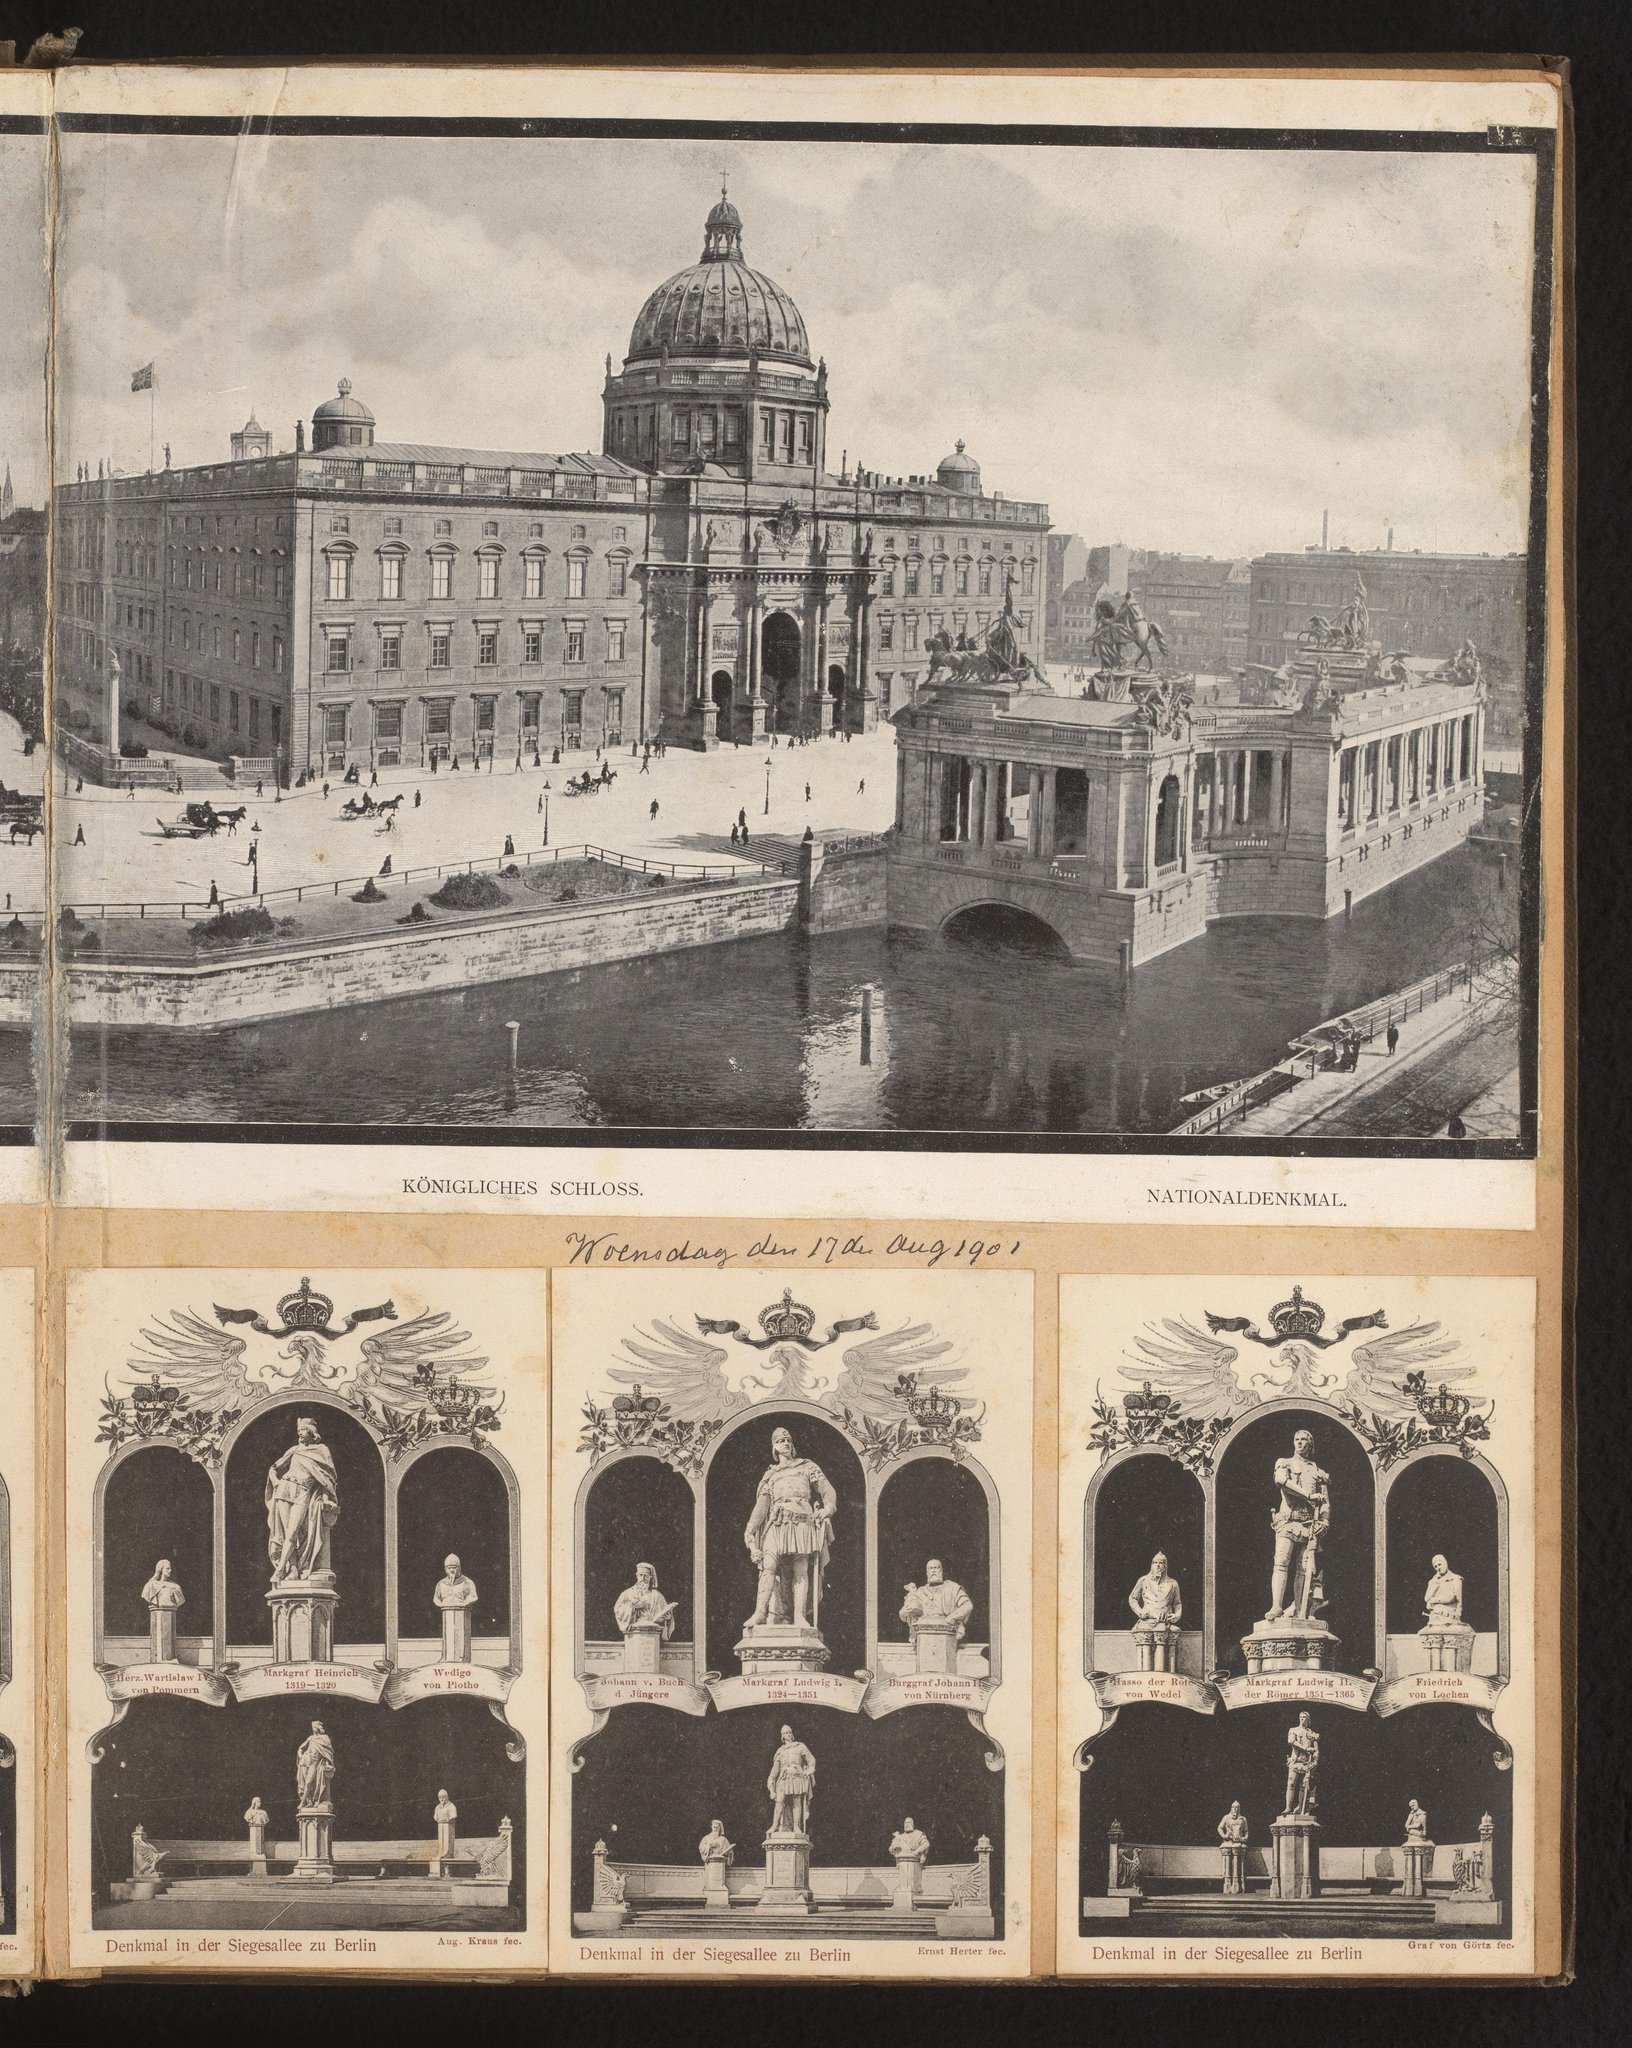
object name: photomechanical print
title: Panorama op het Berliner Stadtschloss en beelden langs de Siegesallee, Berlijn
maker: Anonymous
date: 1896-1901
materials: paper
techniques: photograph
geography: berlin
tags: palace, piece of sculpture, reproduction of a piece of sculpture, monument, statue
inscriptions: title: ‘Denkmal in der Siegesallee zu Berlin (...)’, inscription: ‘Woensdag den 17de Aug. 1901’, inscription: ‘Königliches Schloss. Nationaldenkmal.’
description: De bovenste prent op deze pagina loopt door op de vorige pagina; zie RP-F-2003-40-6.